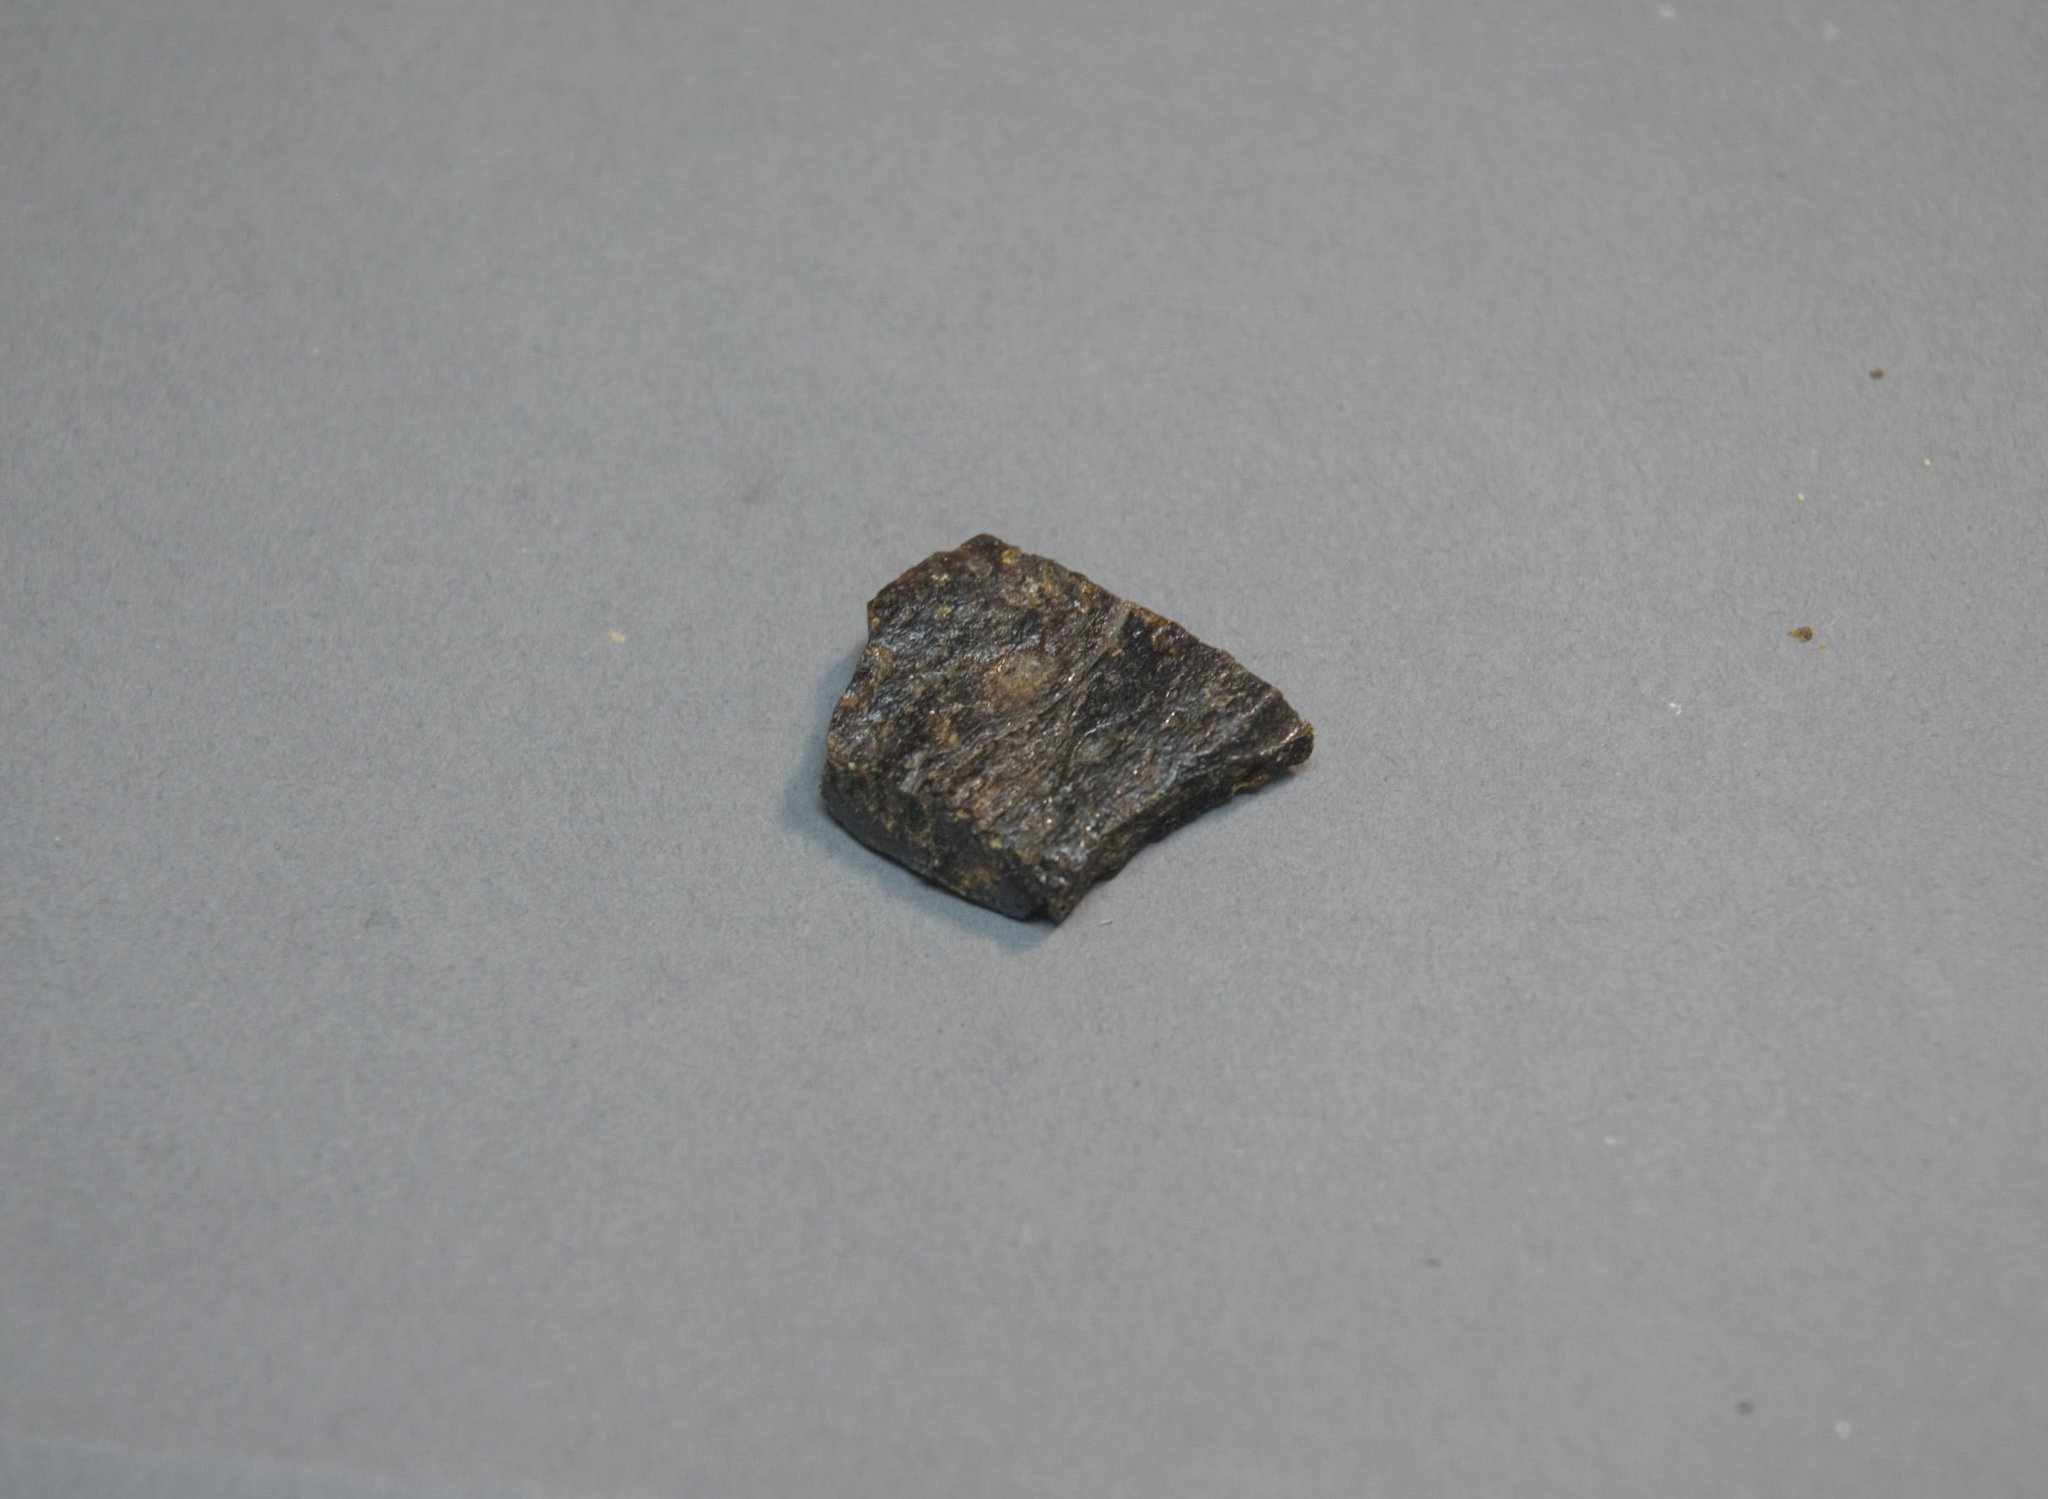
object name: shellac specimen in plastic box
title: Shellac Specimen for Jade Carving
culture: chinese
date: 1901-2000